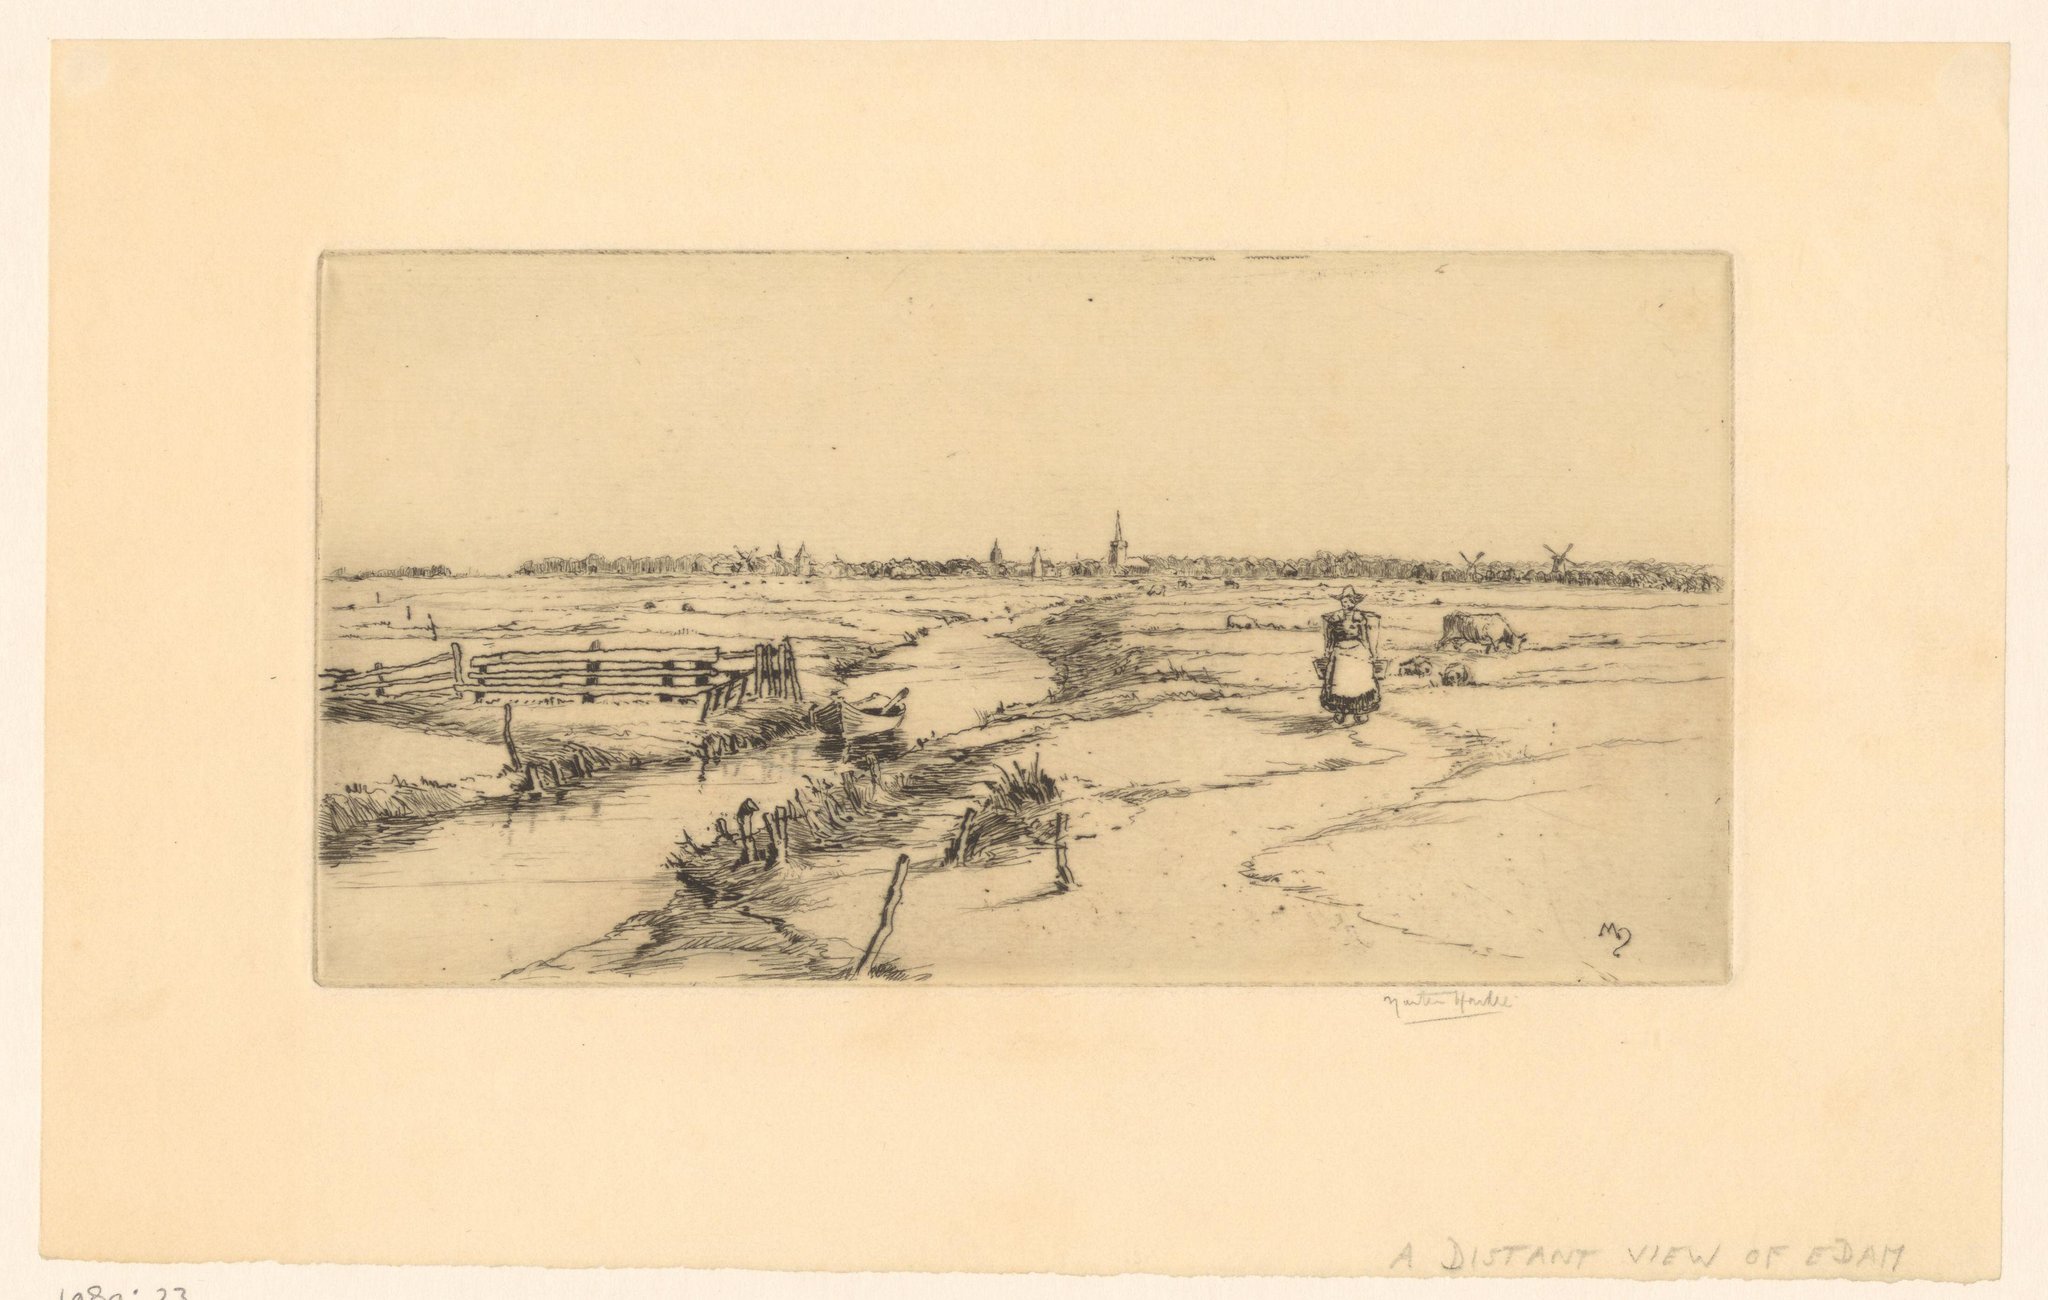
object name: print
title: A Distant view of Edam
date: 1911-1912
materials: paper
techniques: etching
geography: edam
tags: meadow, pasture (+ landscape with figures, staffage)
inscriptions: collector's mark: Lugt 2228, annotation: ‘Martin Hardie’, collector's mark: Lugt 2760